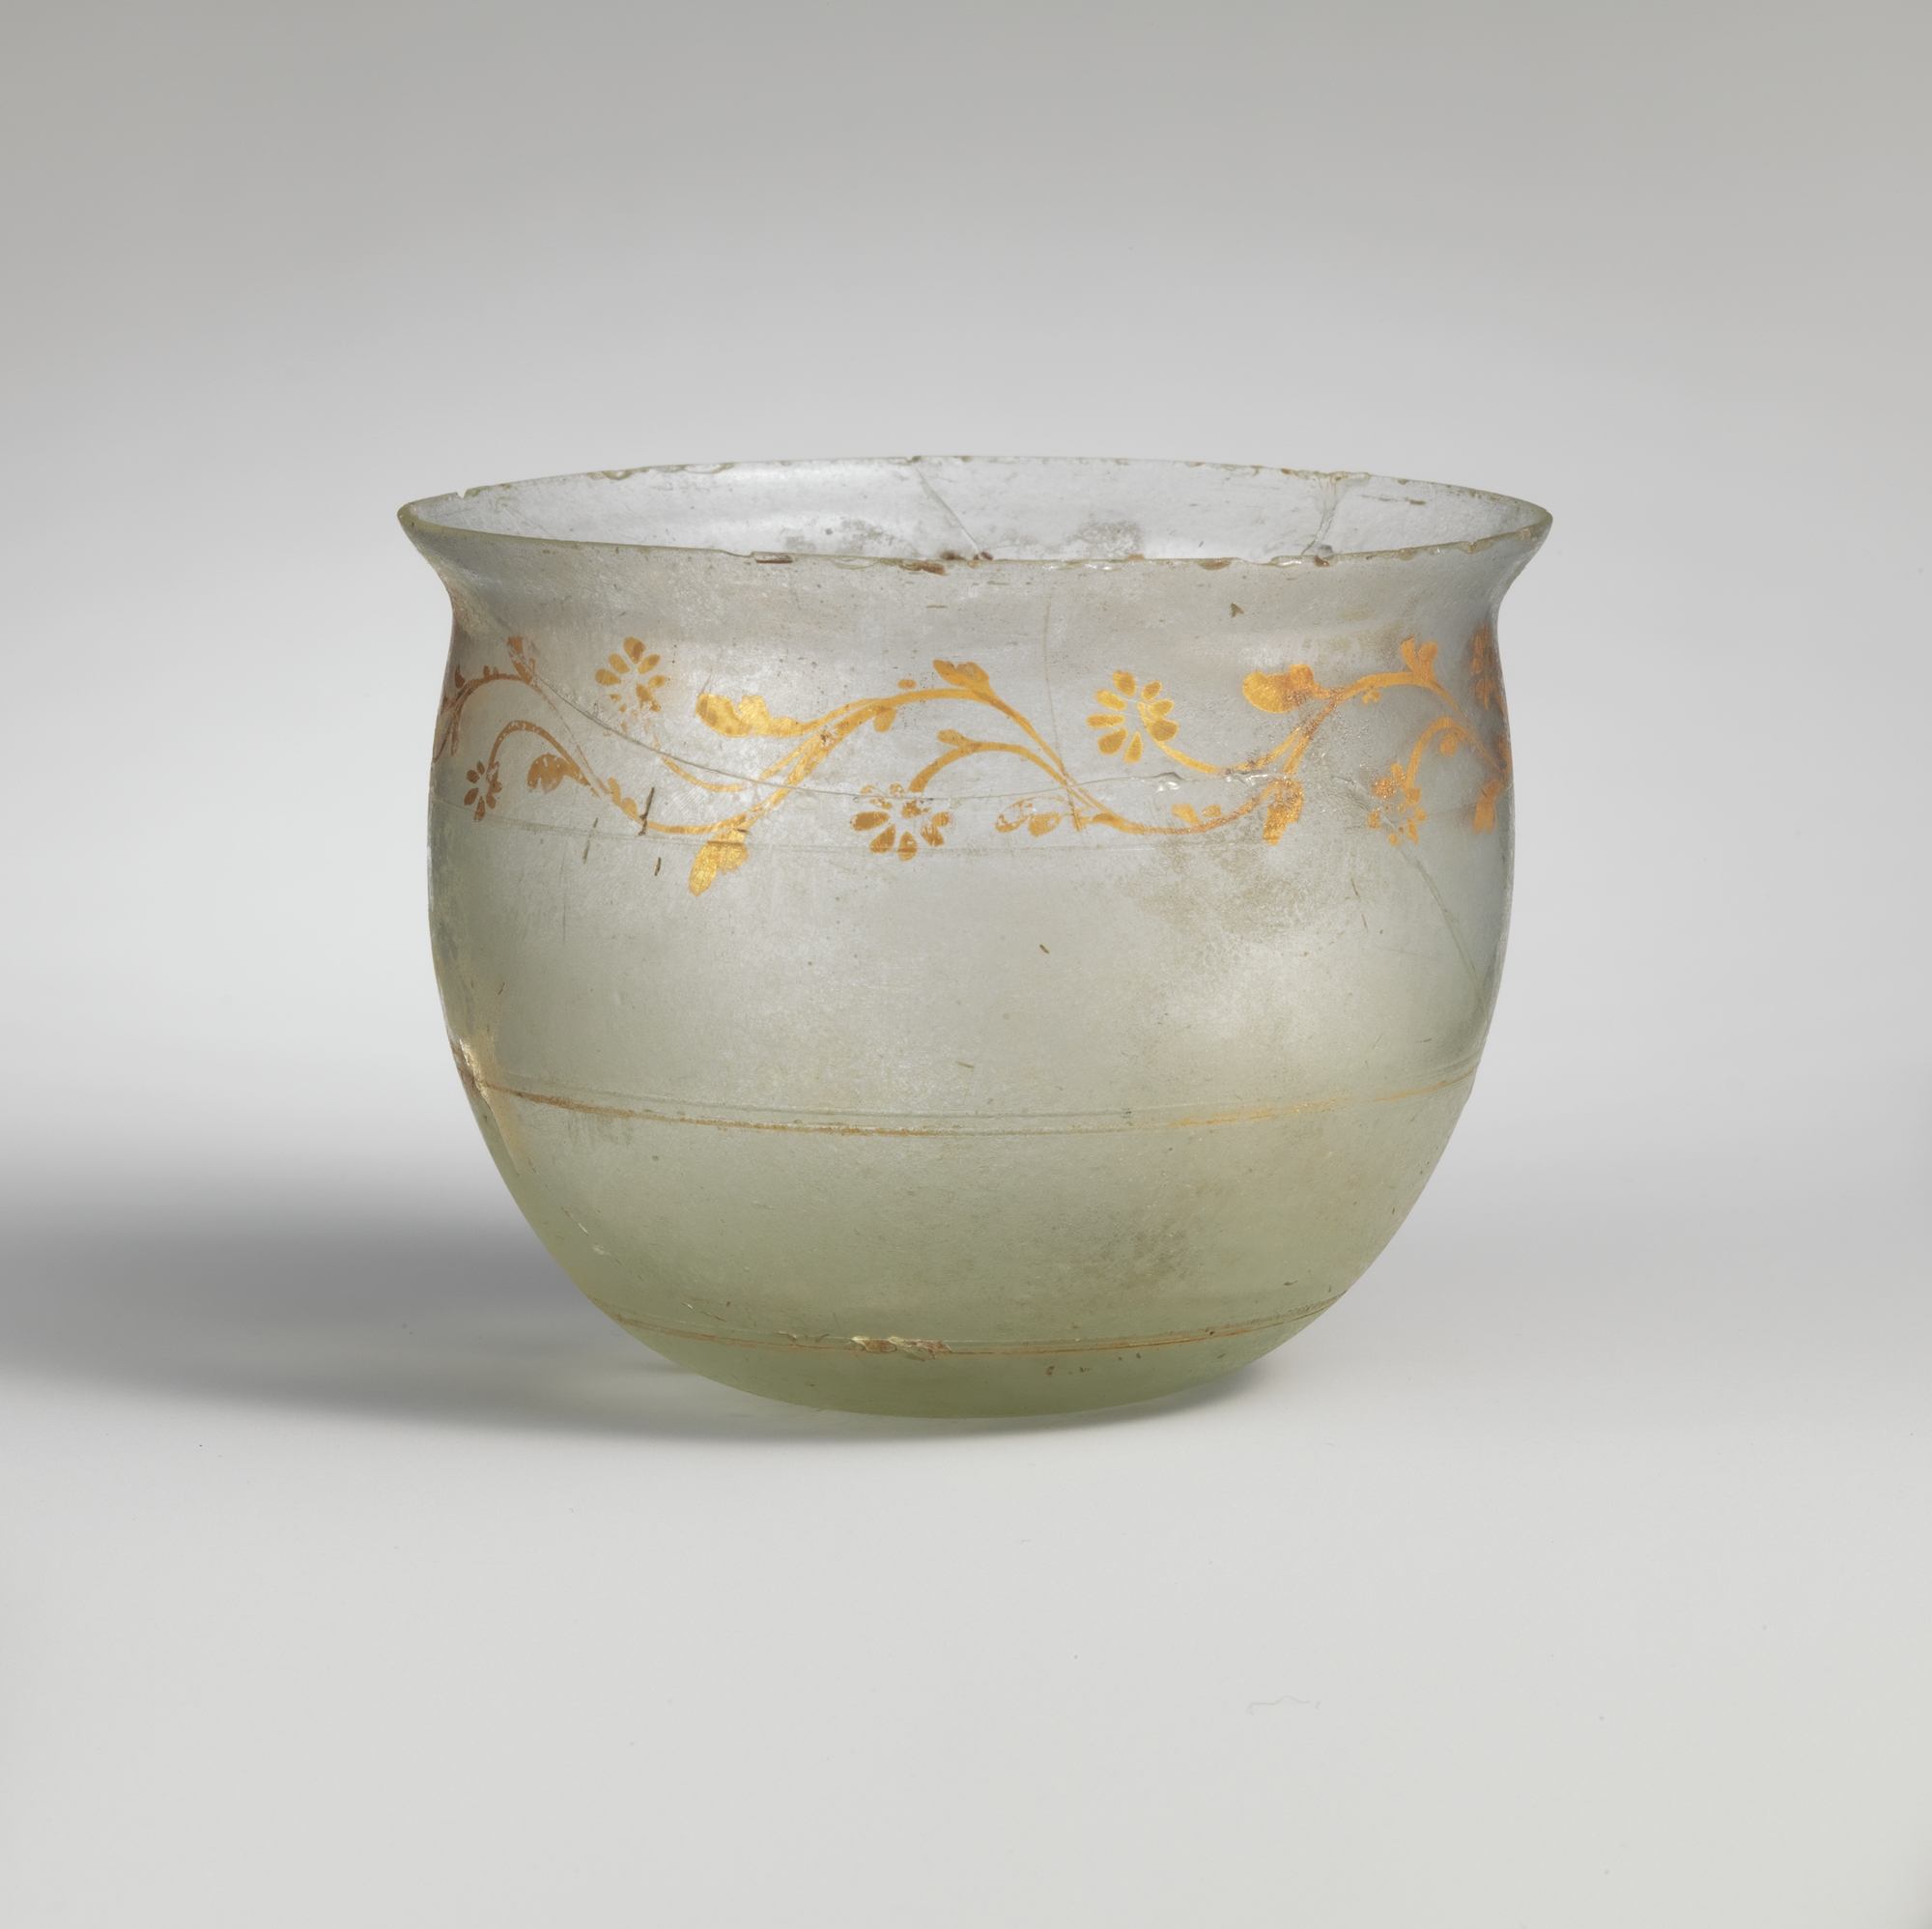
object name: bowl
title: Glass bowl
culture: roman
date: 1-200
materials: glass, gold